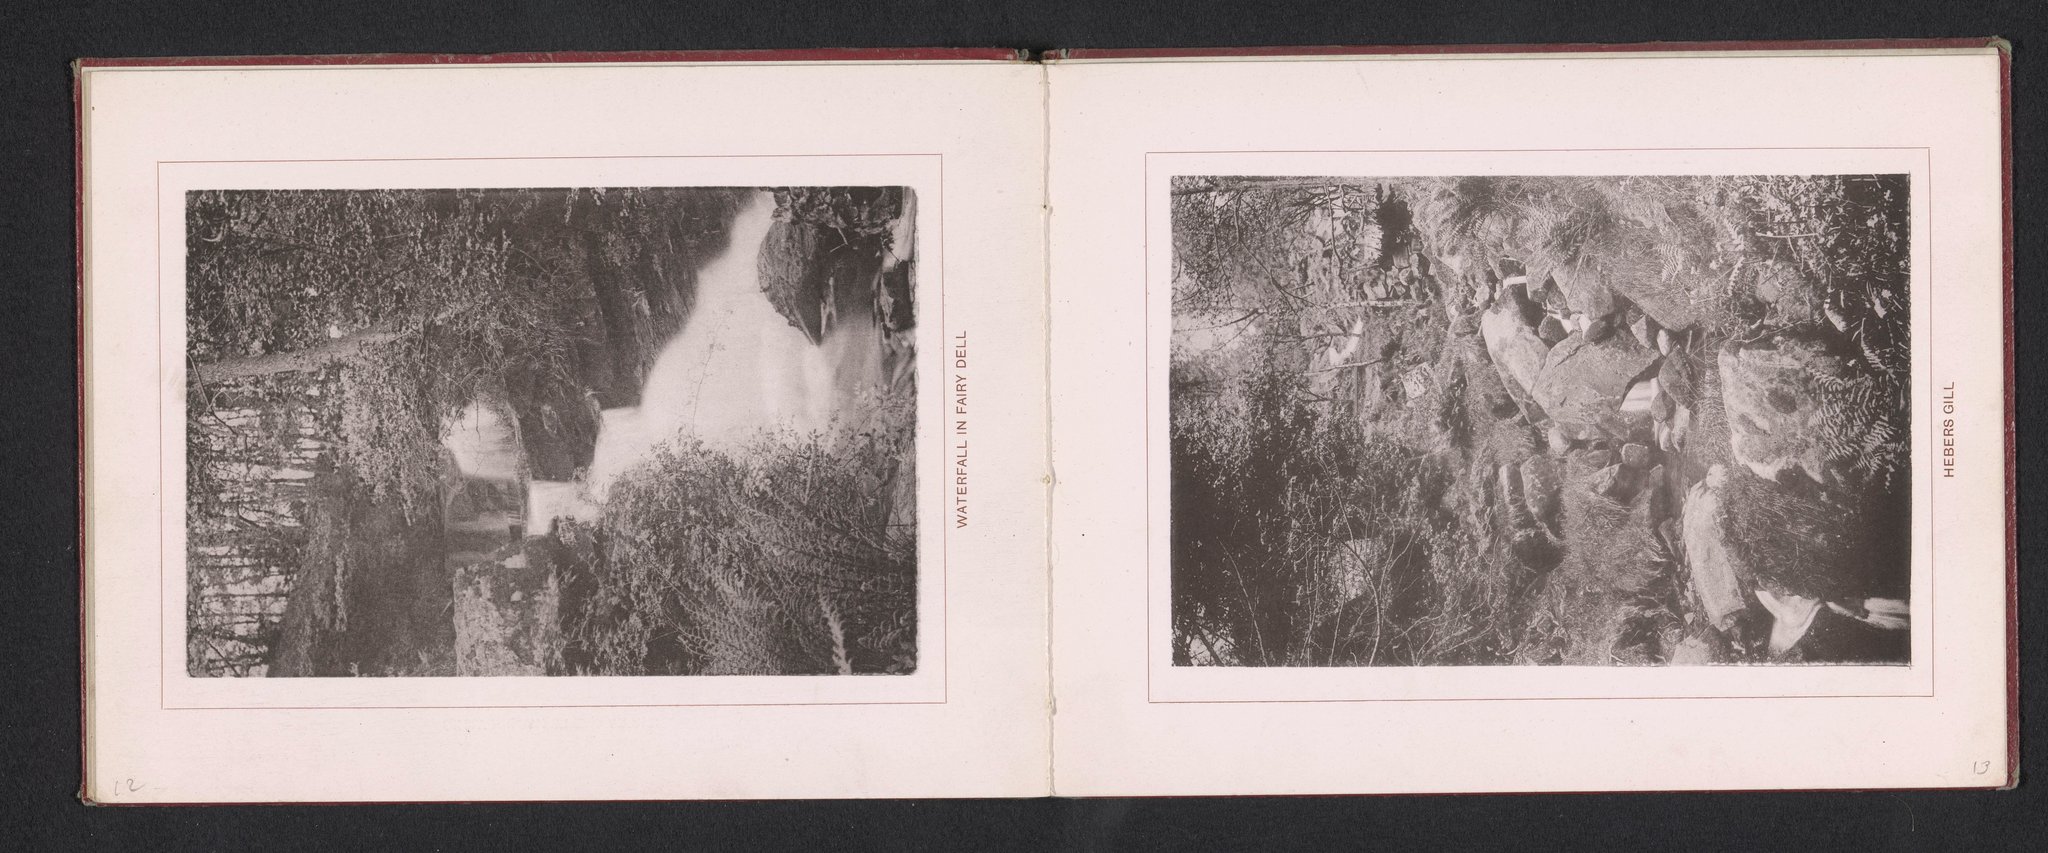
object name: page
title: Hebers Gill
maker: Anonymous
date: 1890-1900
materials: paper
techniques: photograph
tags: brook